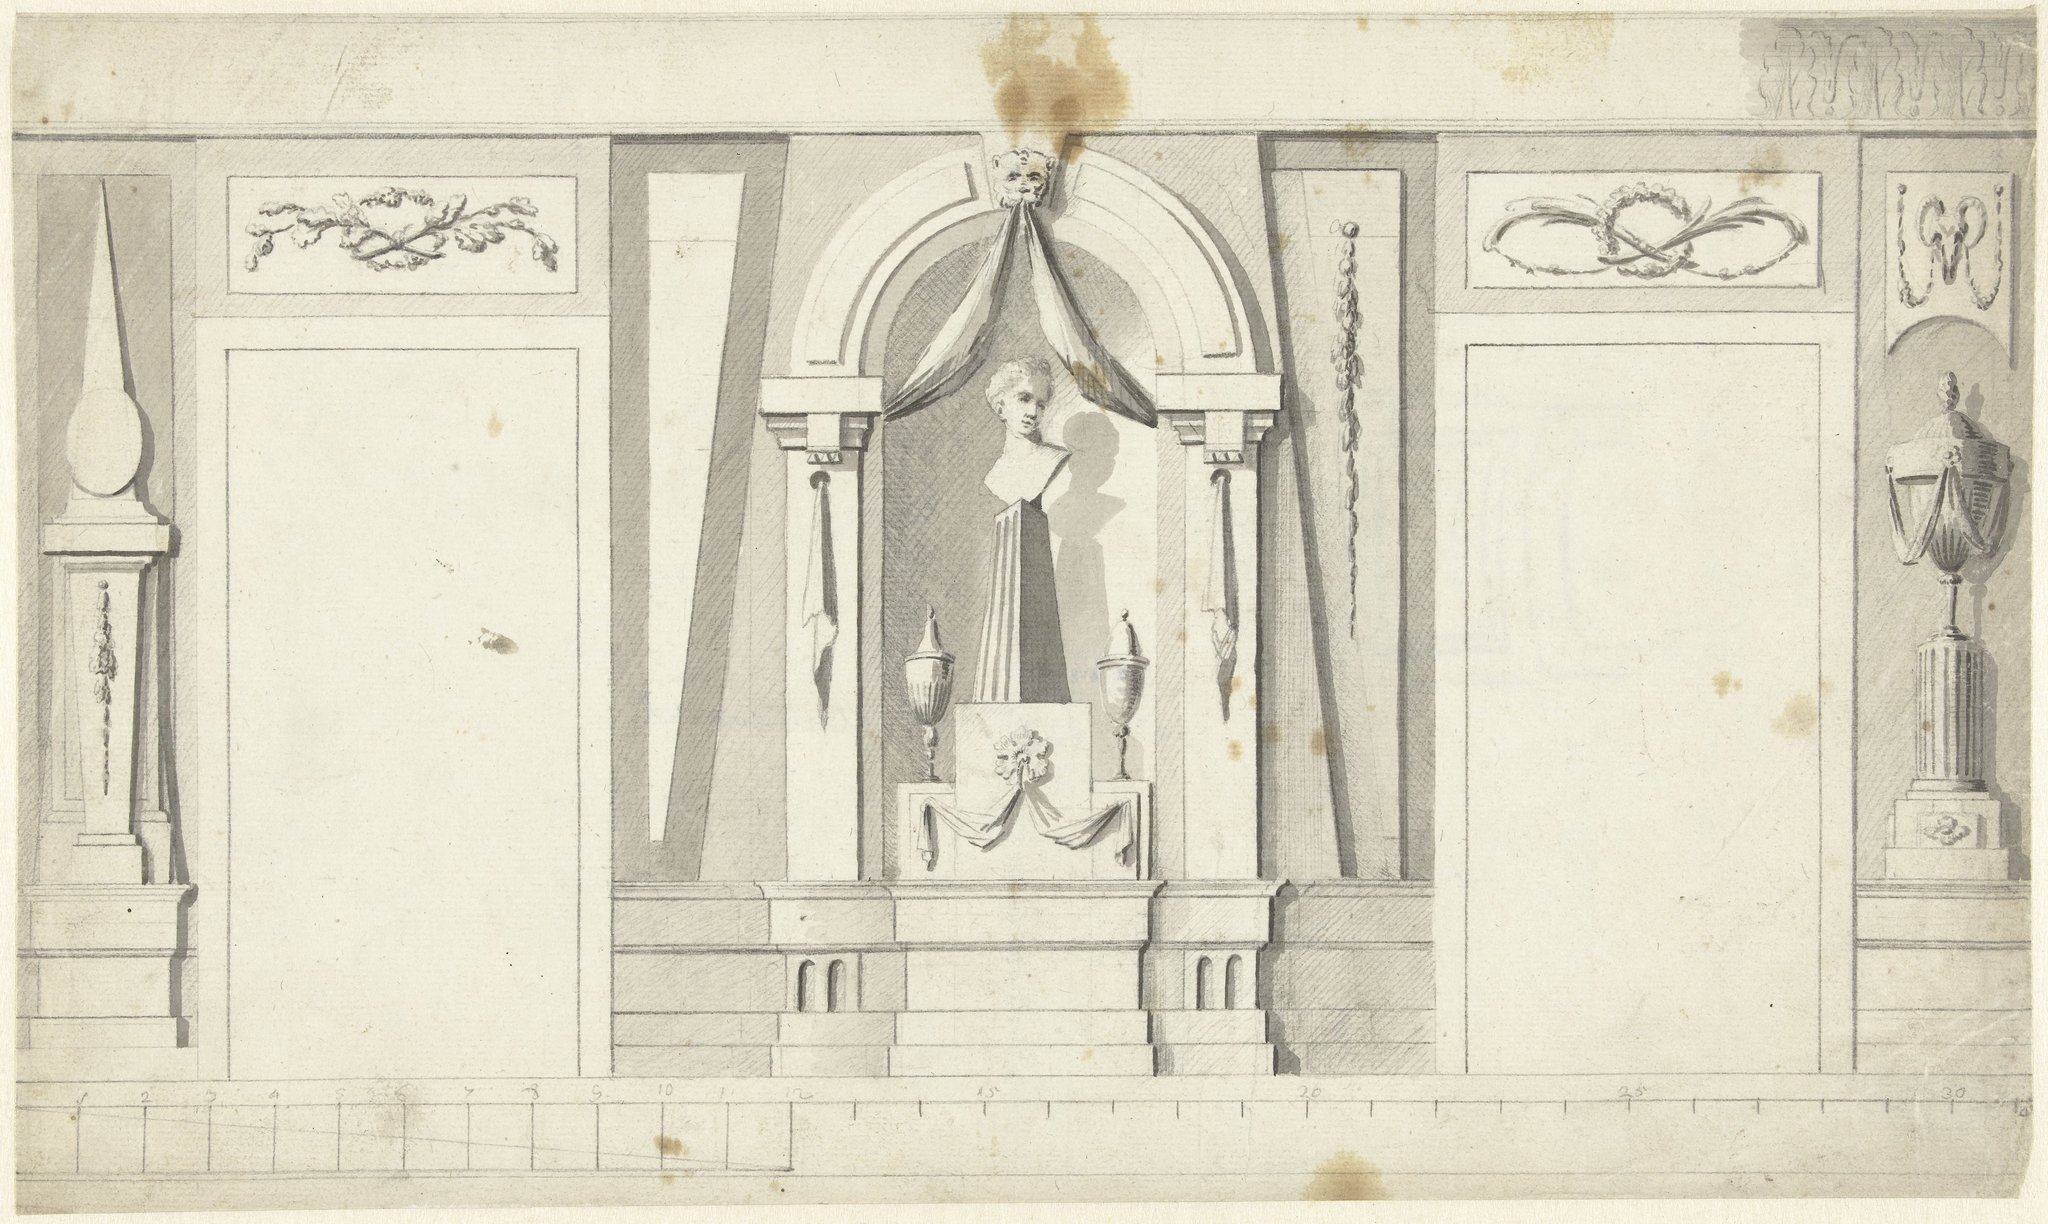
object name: drawing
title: Ontwerp voor kamerversiering met tussen twee deuren een buste op een voet tussen twee urnen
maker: abraham meertens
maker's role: draughtsman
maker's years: 1757-1823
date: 1767-1823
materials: ink, paper, pencil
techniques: brush, pen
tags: wall-covering